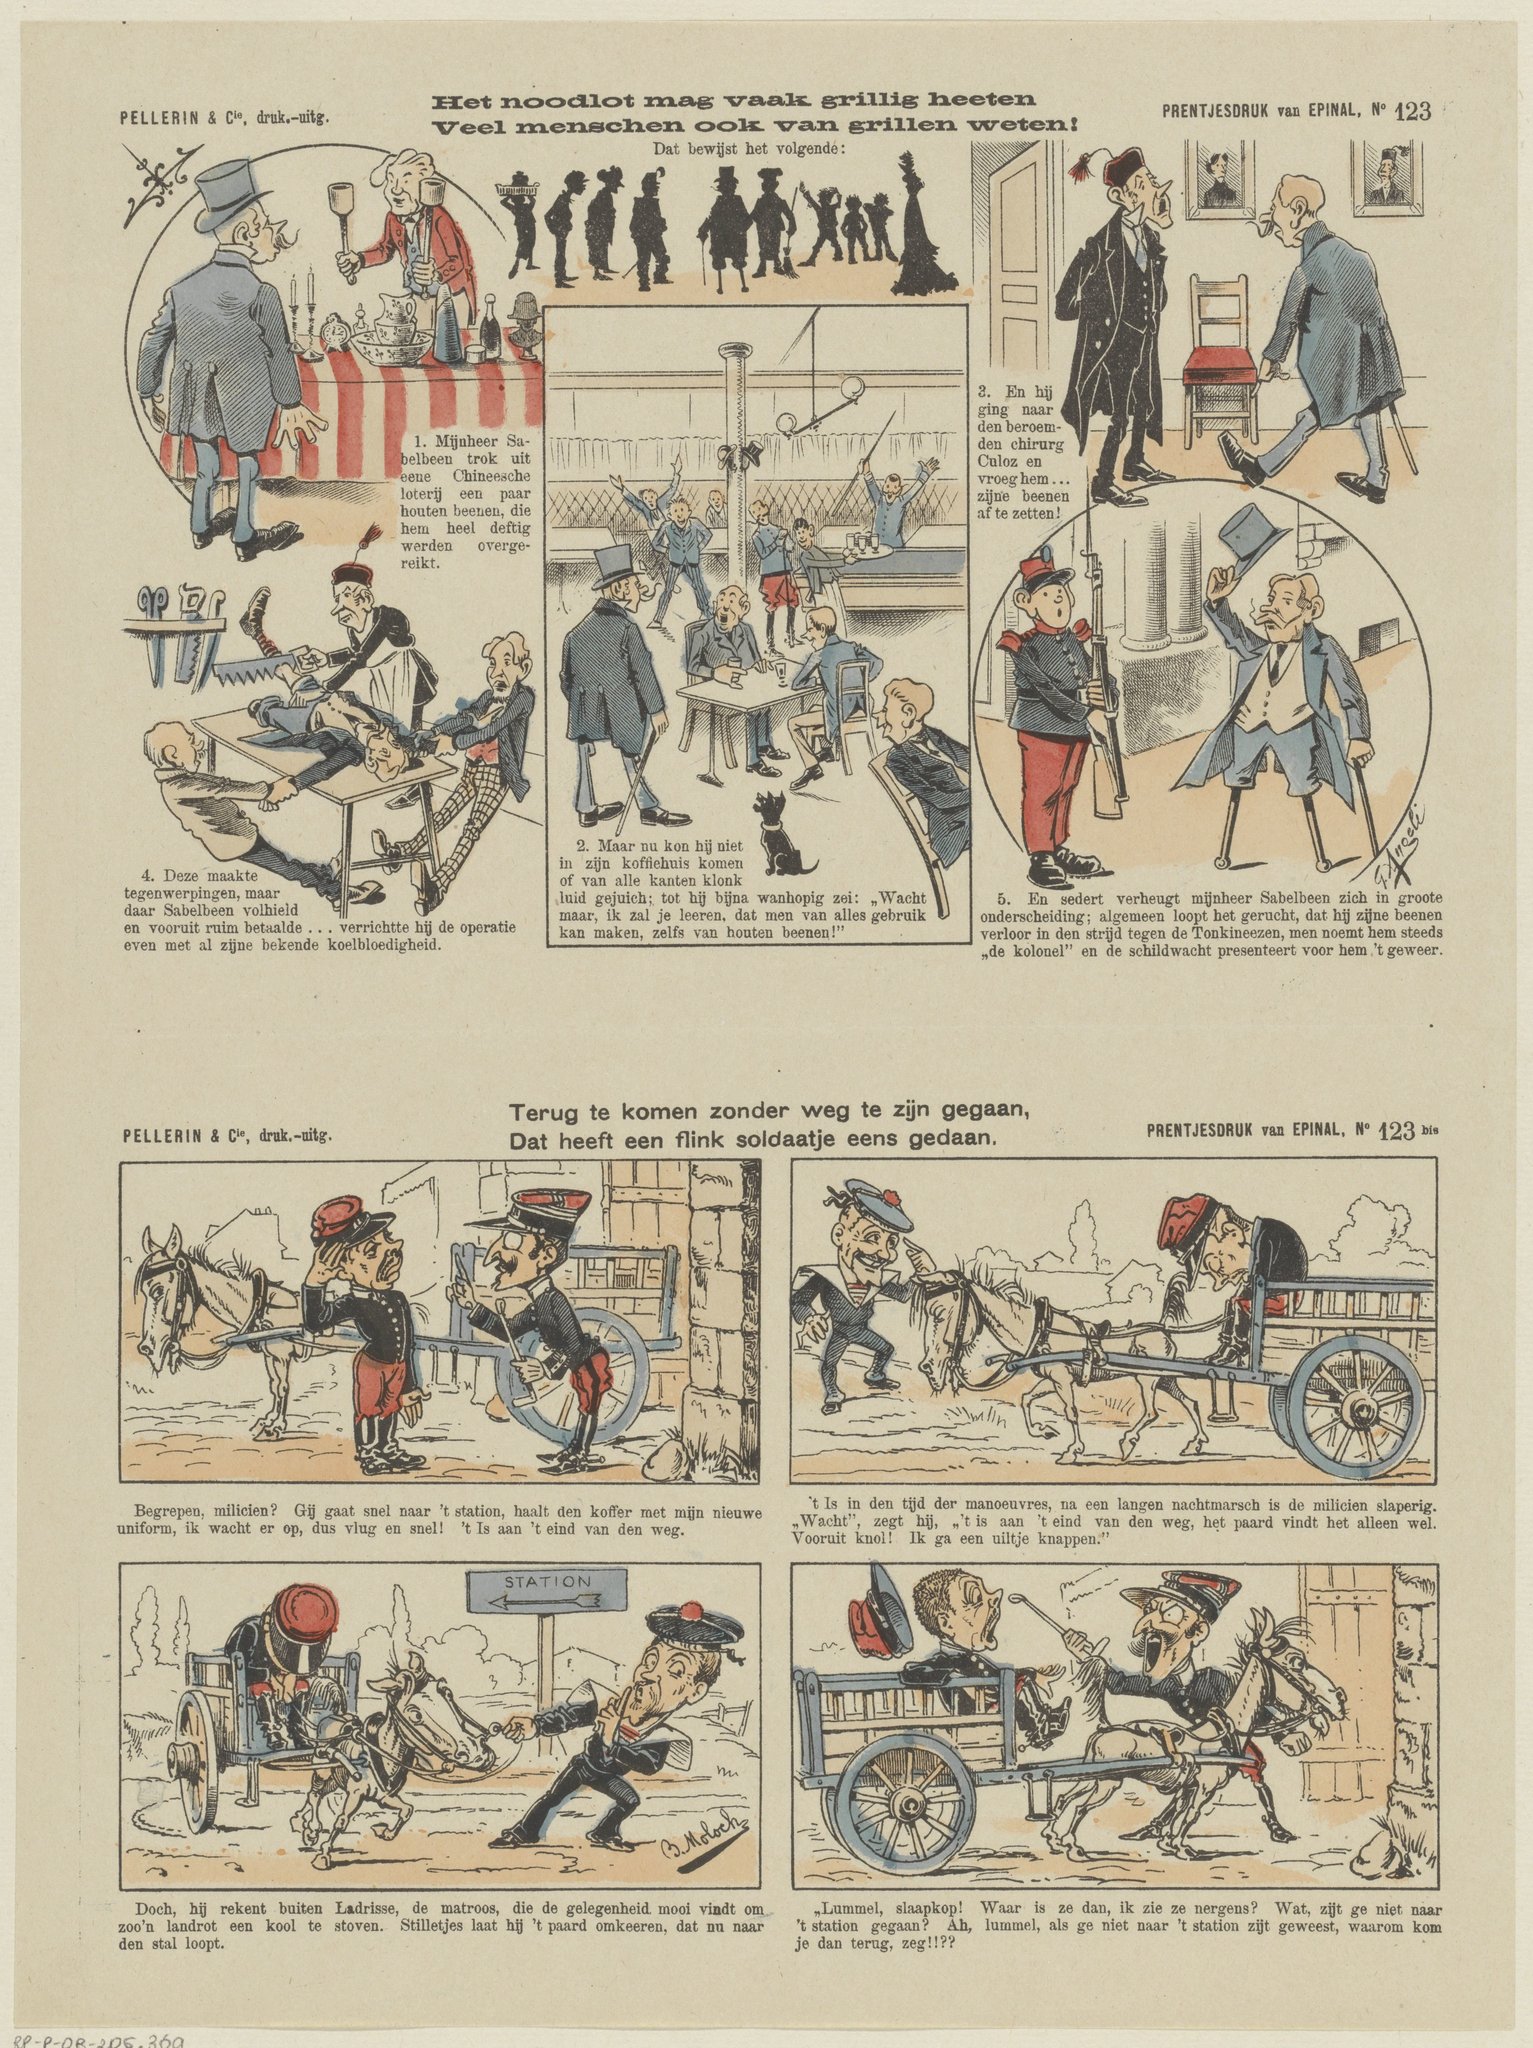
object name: popular print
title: Prentjesdruk van Epinal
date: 1902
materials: paper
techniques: colour, letterpress printing, lithograph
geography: epinal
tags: prosthesis, the soldier; the soldier's life, amputation, sleeping; unconsciousness, comedy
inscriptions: collector's mark: Lugt 2760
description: Blad met 9 voorstellingen. Boven 5 voorstellingen van meneer Sabelbeen die zijn benen laat vervangen door Chineese houten benen. Onder 4 voorstellingen van een milicien die in slaap valt op de kar. Een matroos draait stiekem de kar om, waardoor de slapende milicien terugkeert zonder zijn taak te hebben volbracht. Onder elke afbeelding een onderschrift. Genummerd rechtsboven: No 123.